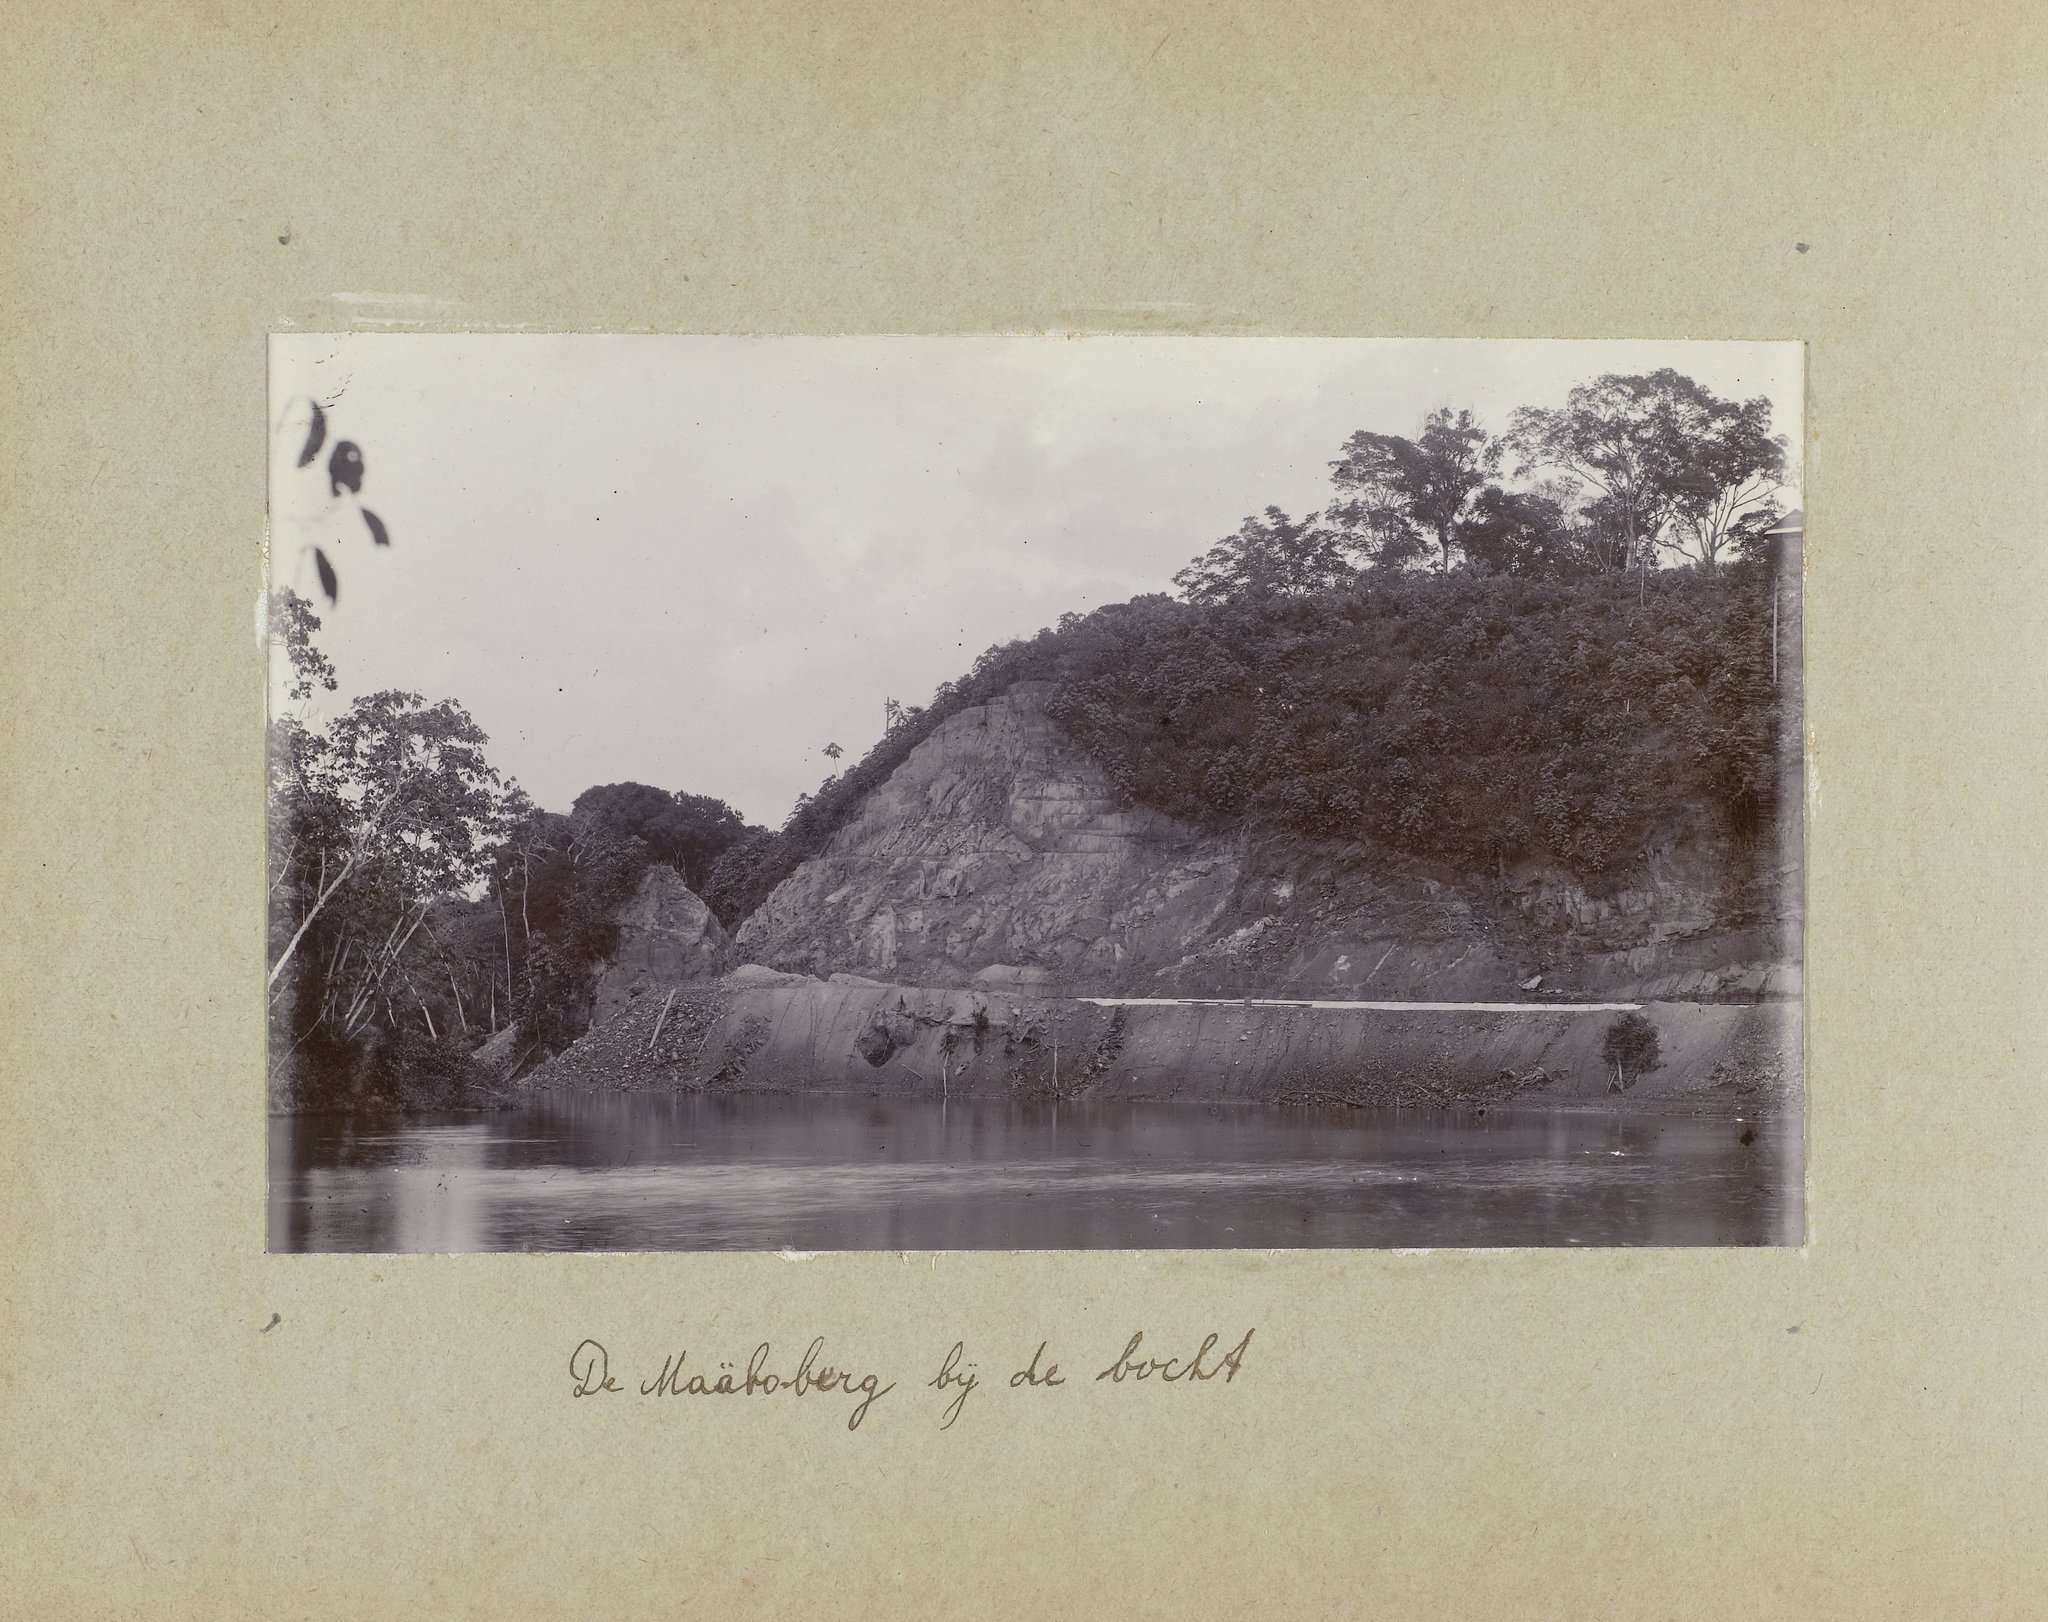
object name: photograph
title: De Mäaboberg bij de bocht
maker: augusta curiel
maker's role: fotograaf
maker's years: 1873-1937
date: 1905-1910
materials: photographic support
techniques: photography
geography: suriname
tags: jacob evert wesenhagen, railway, tramway; rack railway, suriname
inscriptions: inscription: ‘De Mäaboberg bij de bocht’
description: De bocht van de nieuwe spoorbaan bij de Maäbo Heuvel. Foto in het fotoalbum over de aanleg van de Lawaspoorweg in Suriname in de jaren 1903-1912. Onderdeel van een groep objecten afkomstig van de familie Wesenhagen in Suriname.